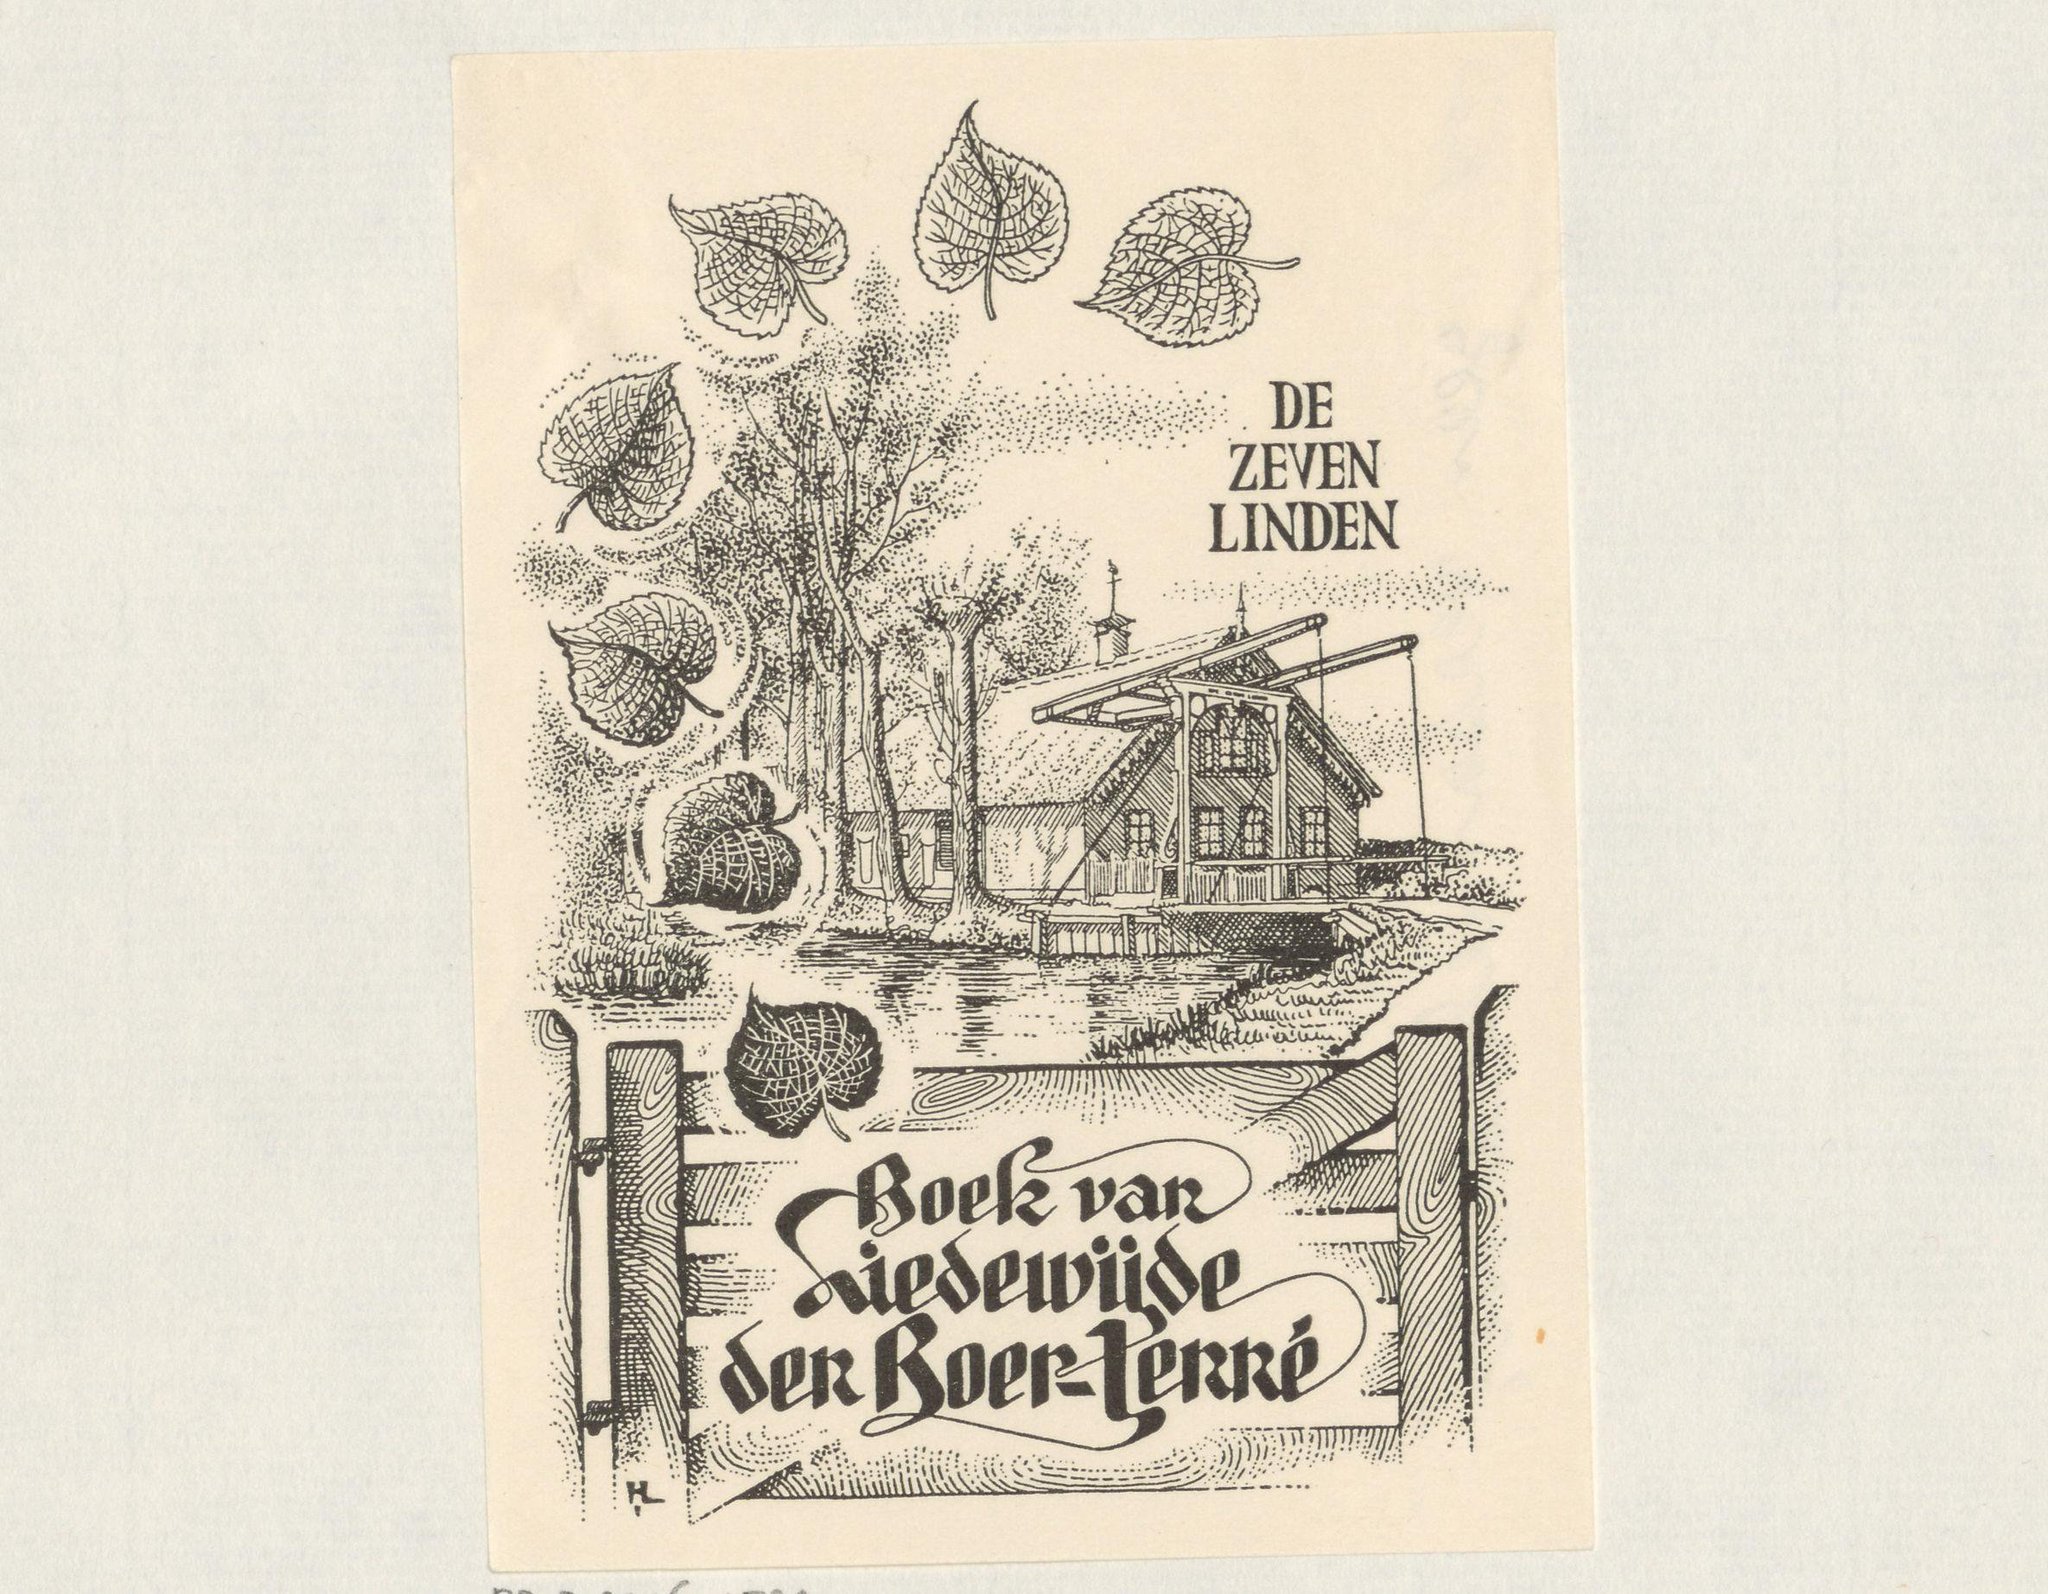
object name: bookplate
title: De zeven linden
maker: Anonymous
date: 1900-1999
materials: paper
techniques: printing block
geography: netherlands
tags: farm (building)